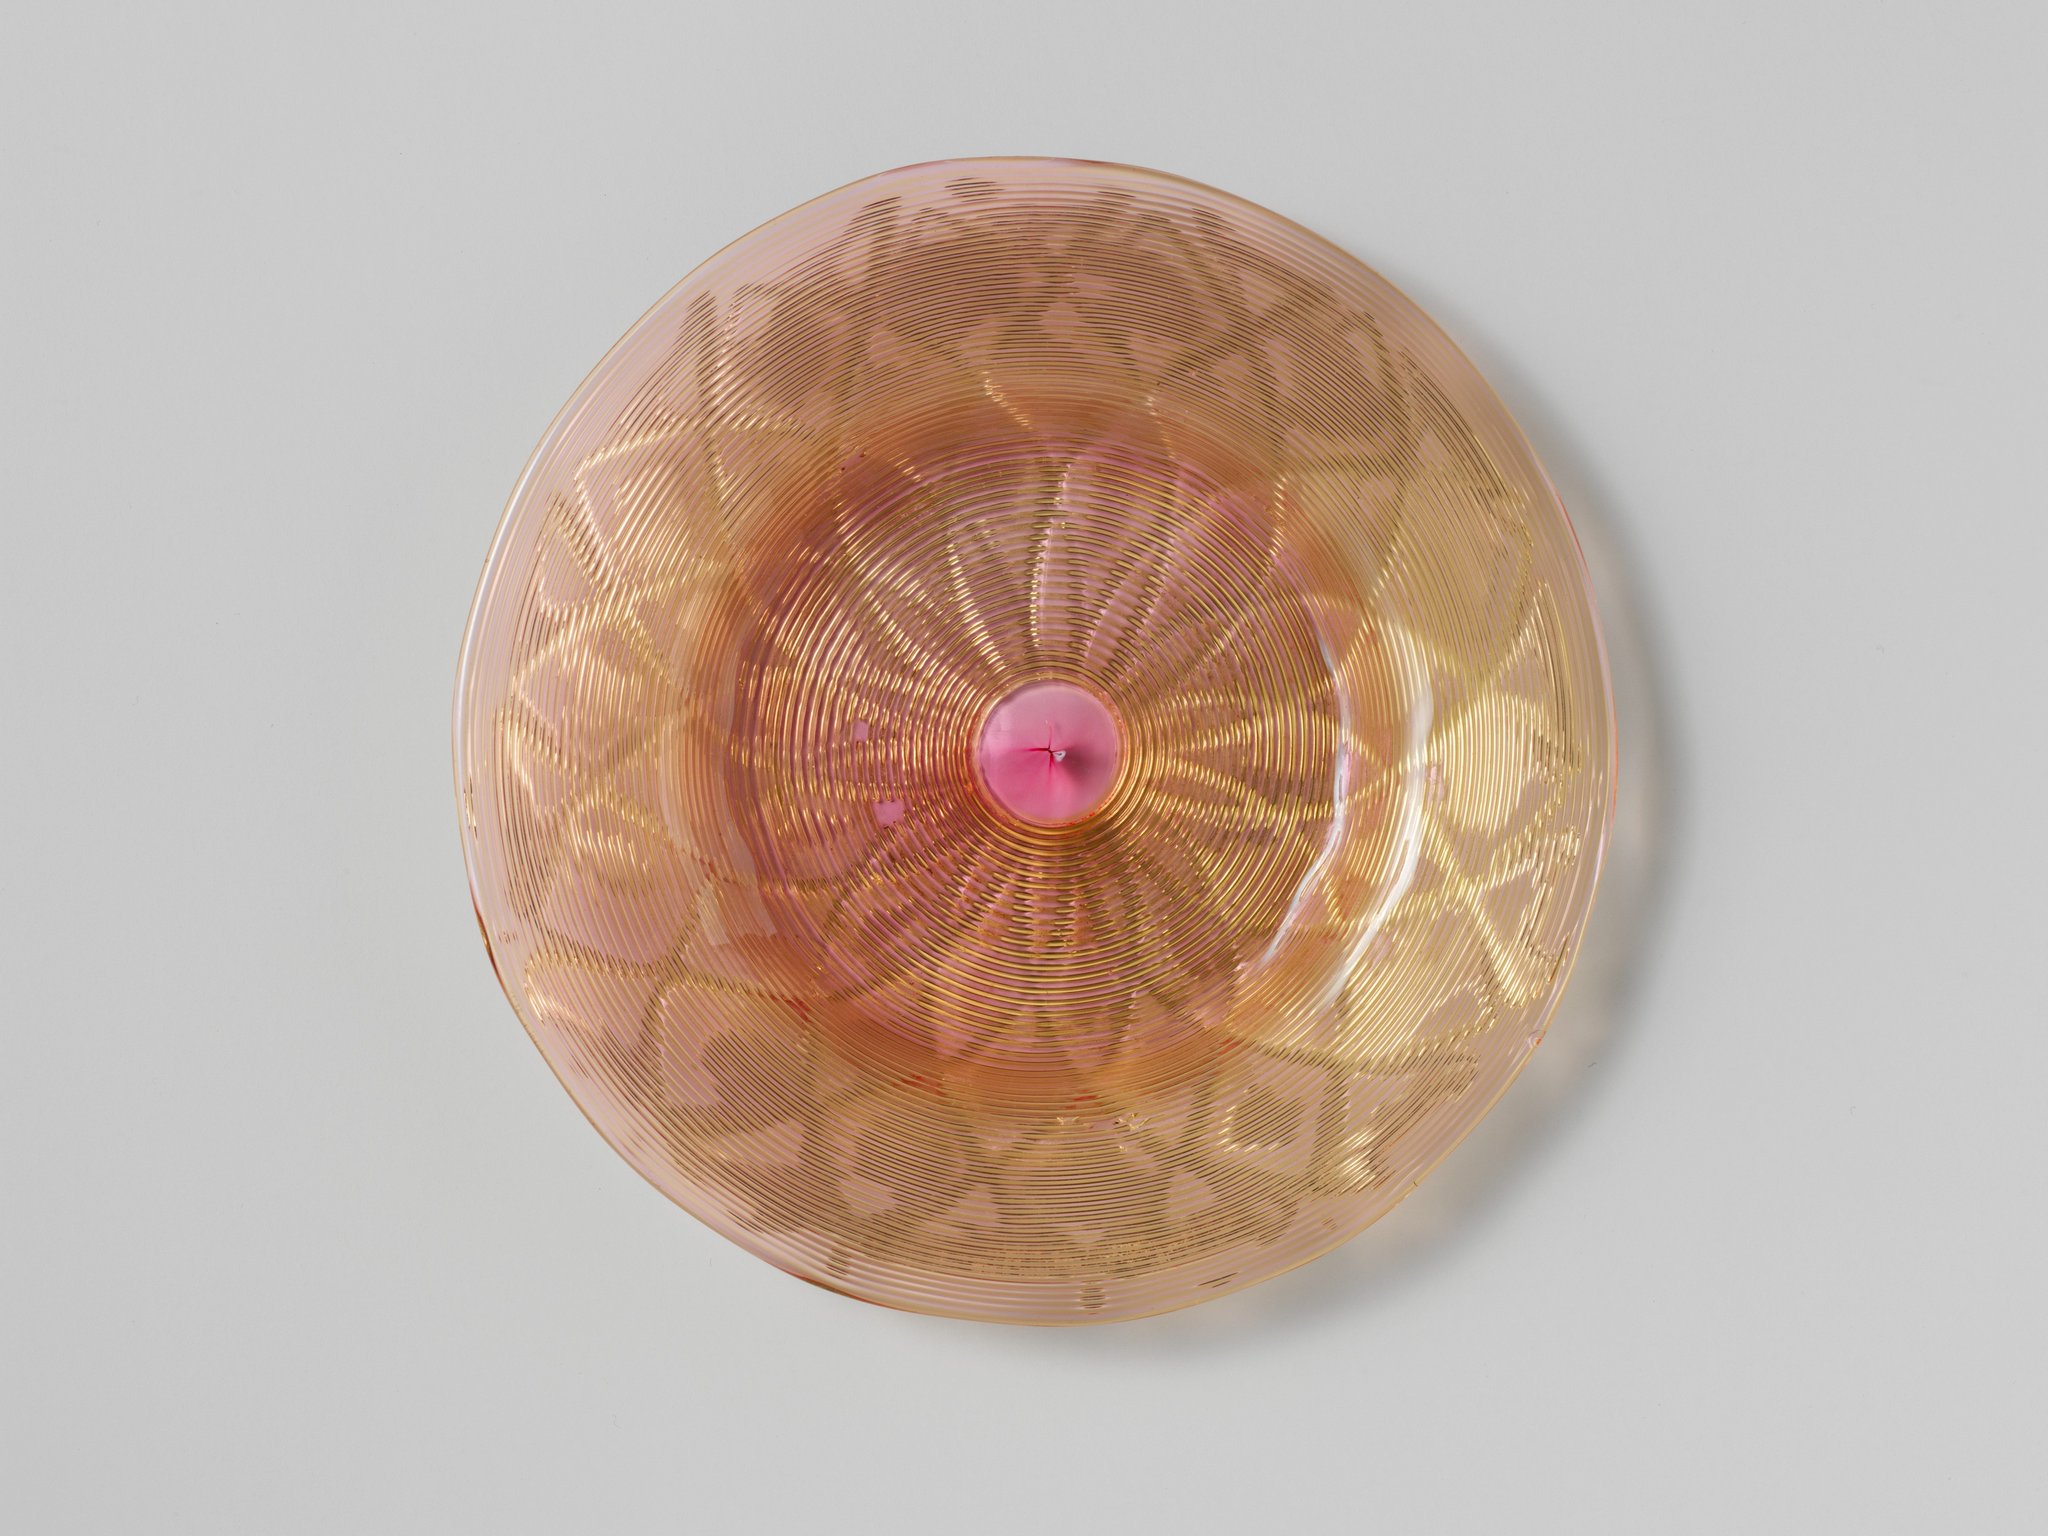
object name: plate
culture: american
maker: boston & sandwich glass company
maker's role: maker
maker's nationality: american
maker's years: 1825-1888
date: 1880-1888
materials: amber, glass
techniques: glassblowing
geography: united states